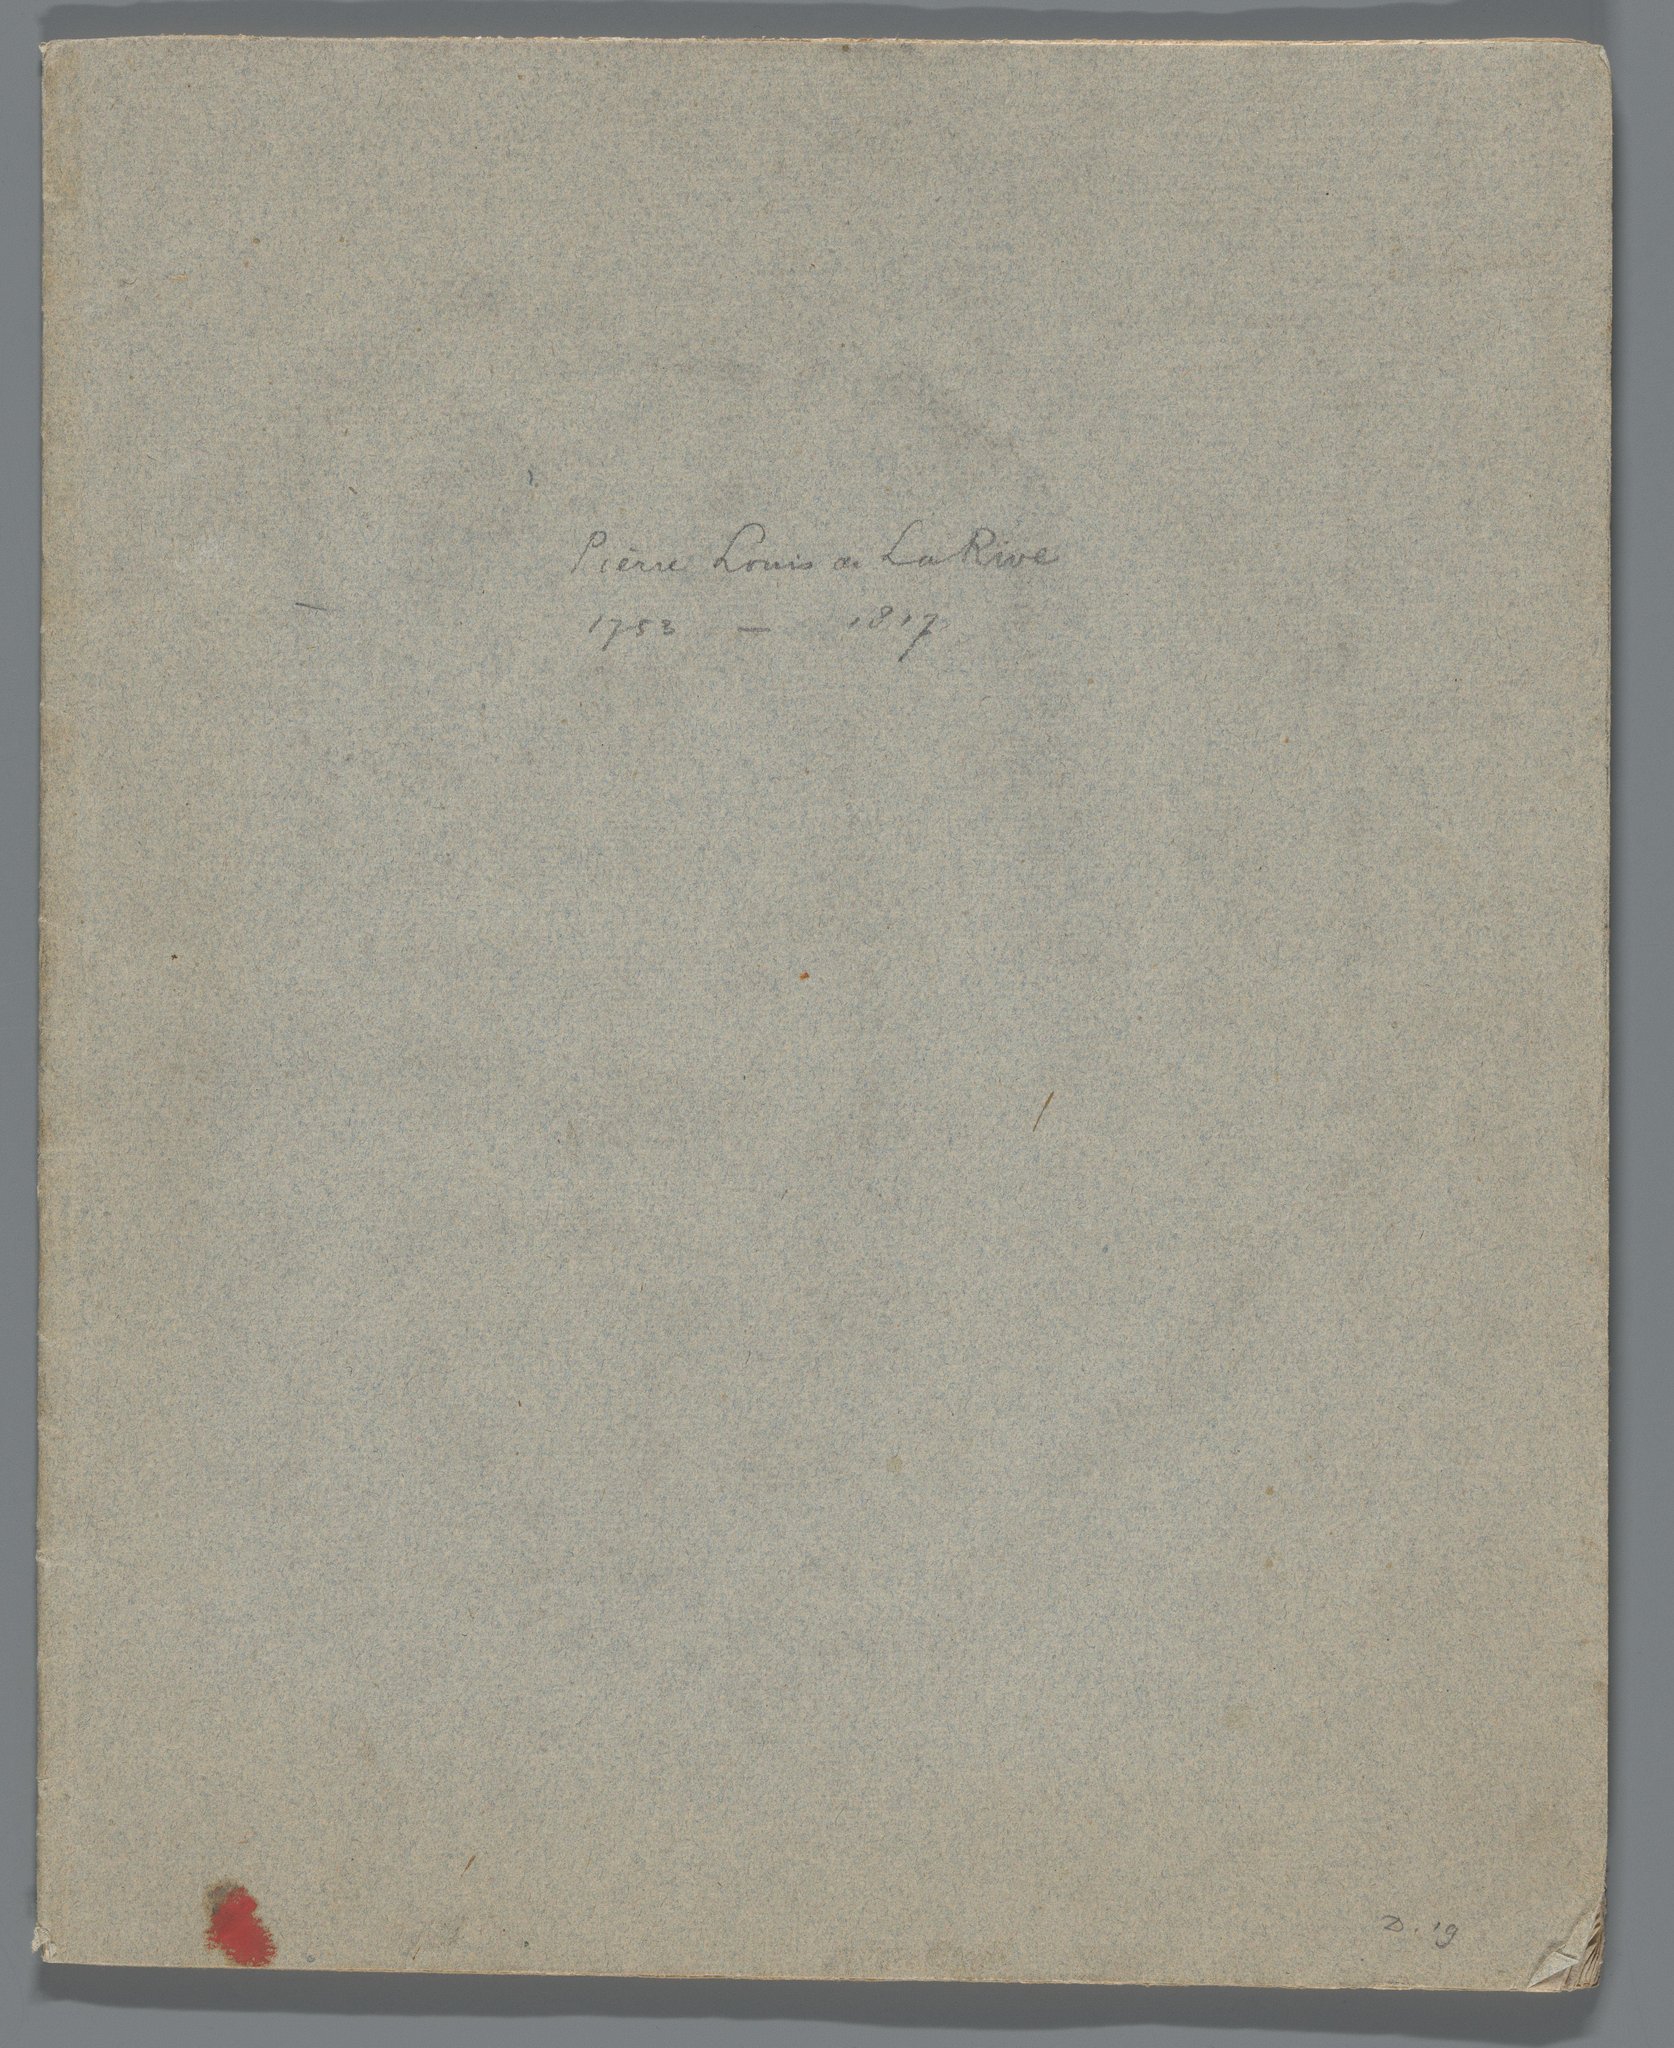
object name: prentrecueil, prentenalbum, prentalbum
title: Essais d'eau forte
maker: pierre-louis de la rive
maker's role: draughtsman, print maker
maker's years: 1753-1817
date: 1800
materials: paper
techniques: bookbinding, etching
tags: landscapes (+ landscape with figures, staffage)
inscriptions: annotation: ‘Pierre-Louis De la Rive’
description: Album met acht prenten uit een serie getiteld 'Essais d'eau forte' met voorstellingen van runderen en ander vee in landschappen op acht bladen.